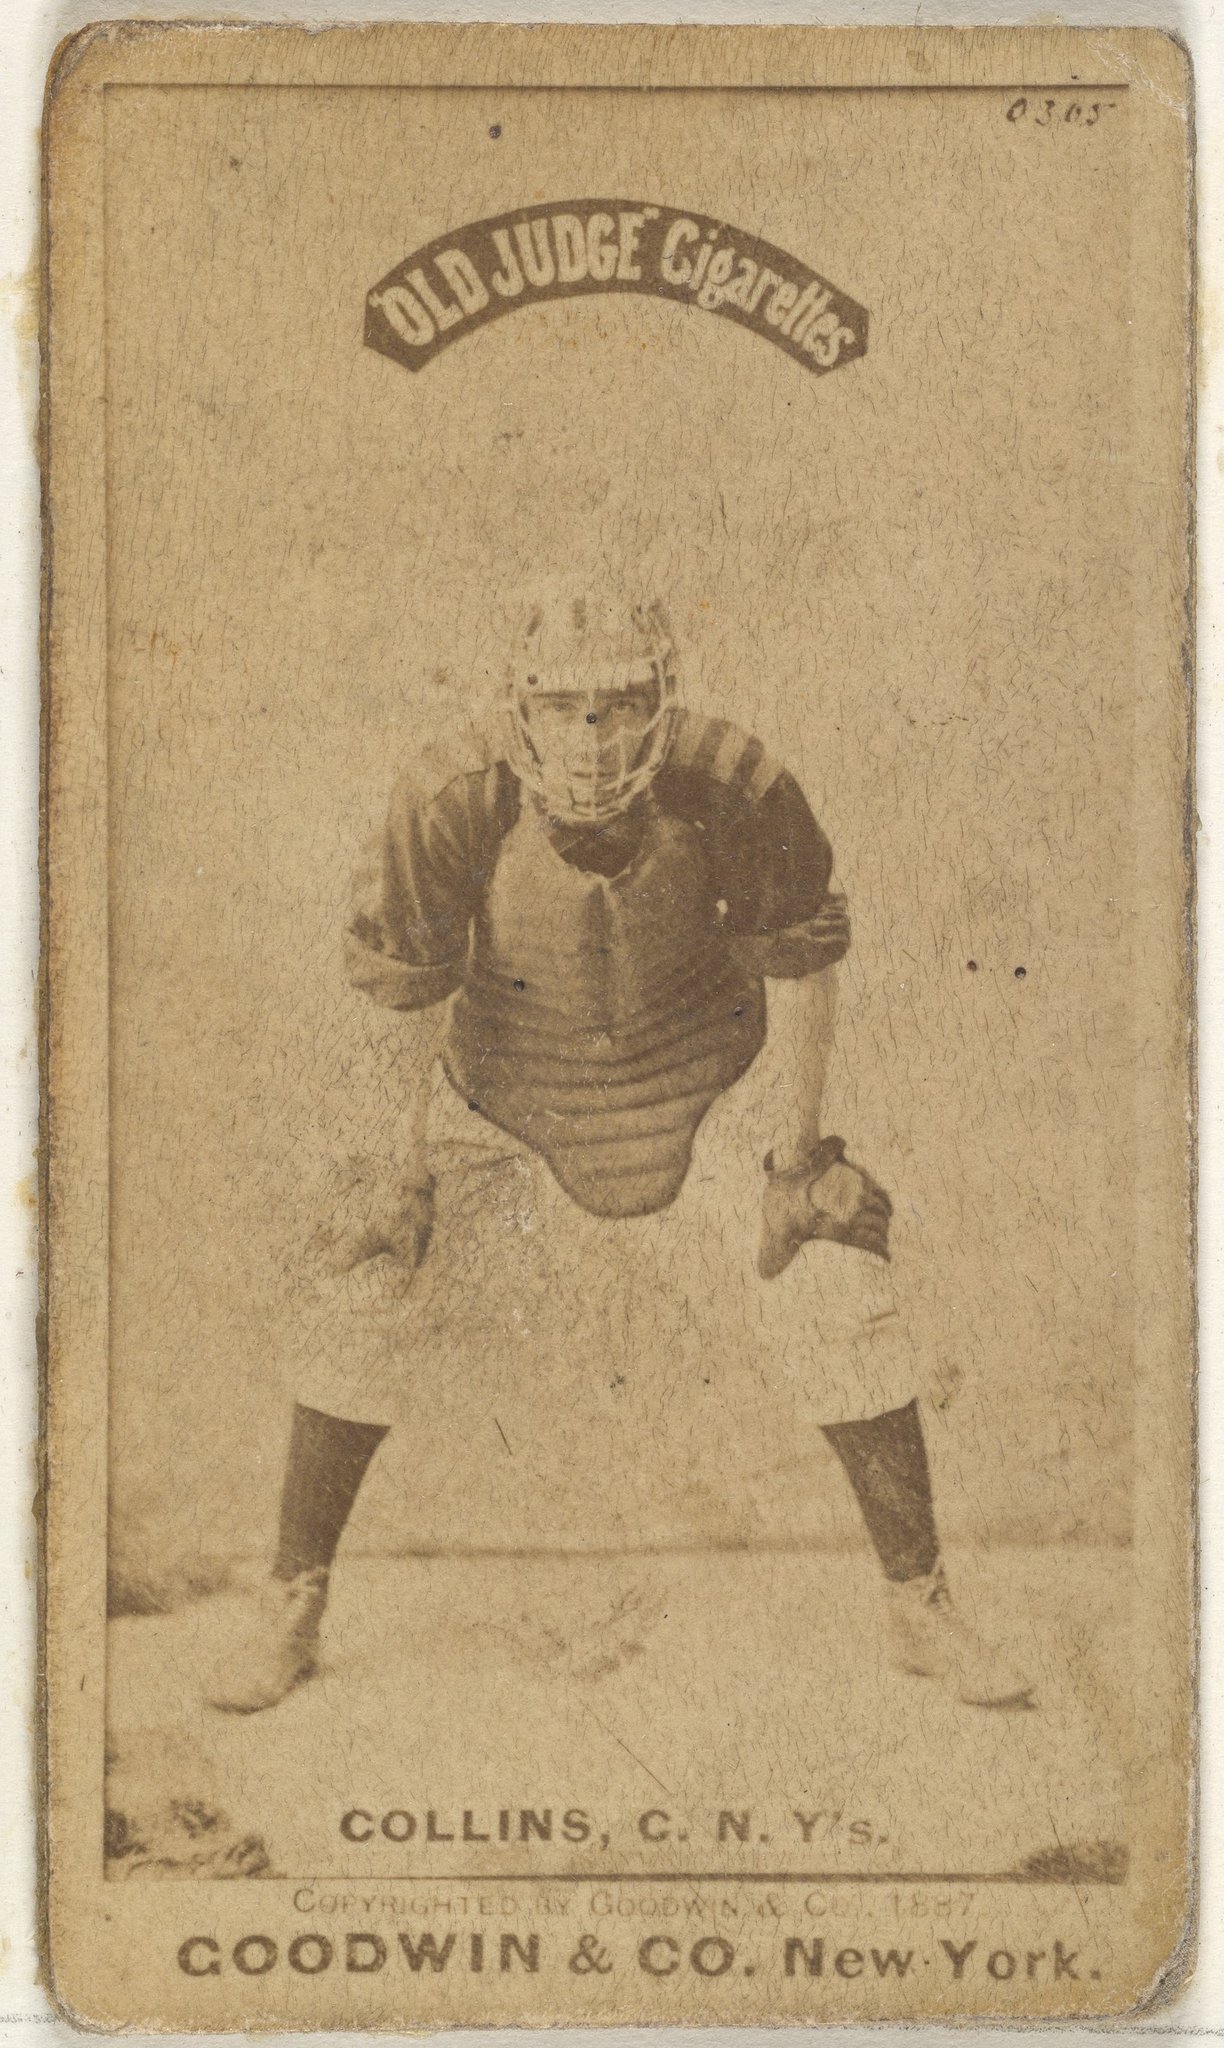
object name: baseball card, photograph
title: Bill Collins, Catcher, New York, from the Old Judge series (N172) for Old Judge Cigarettes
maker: goodwin & company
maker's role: publisher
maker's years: 1850-1950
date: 1887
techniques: albumen silver print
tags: men,portraits,baseball,athletes